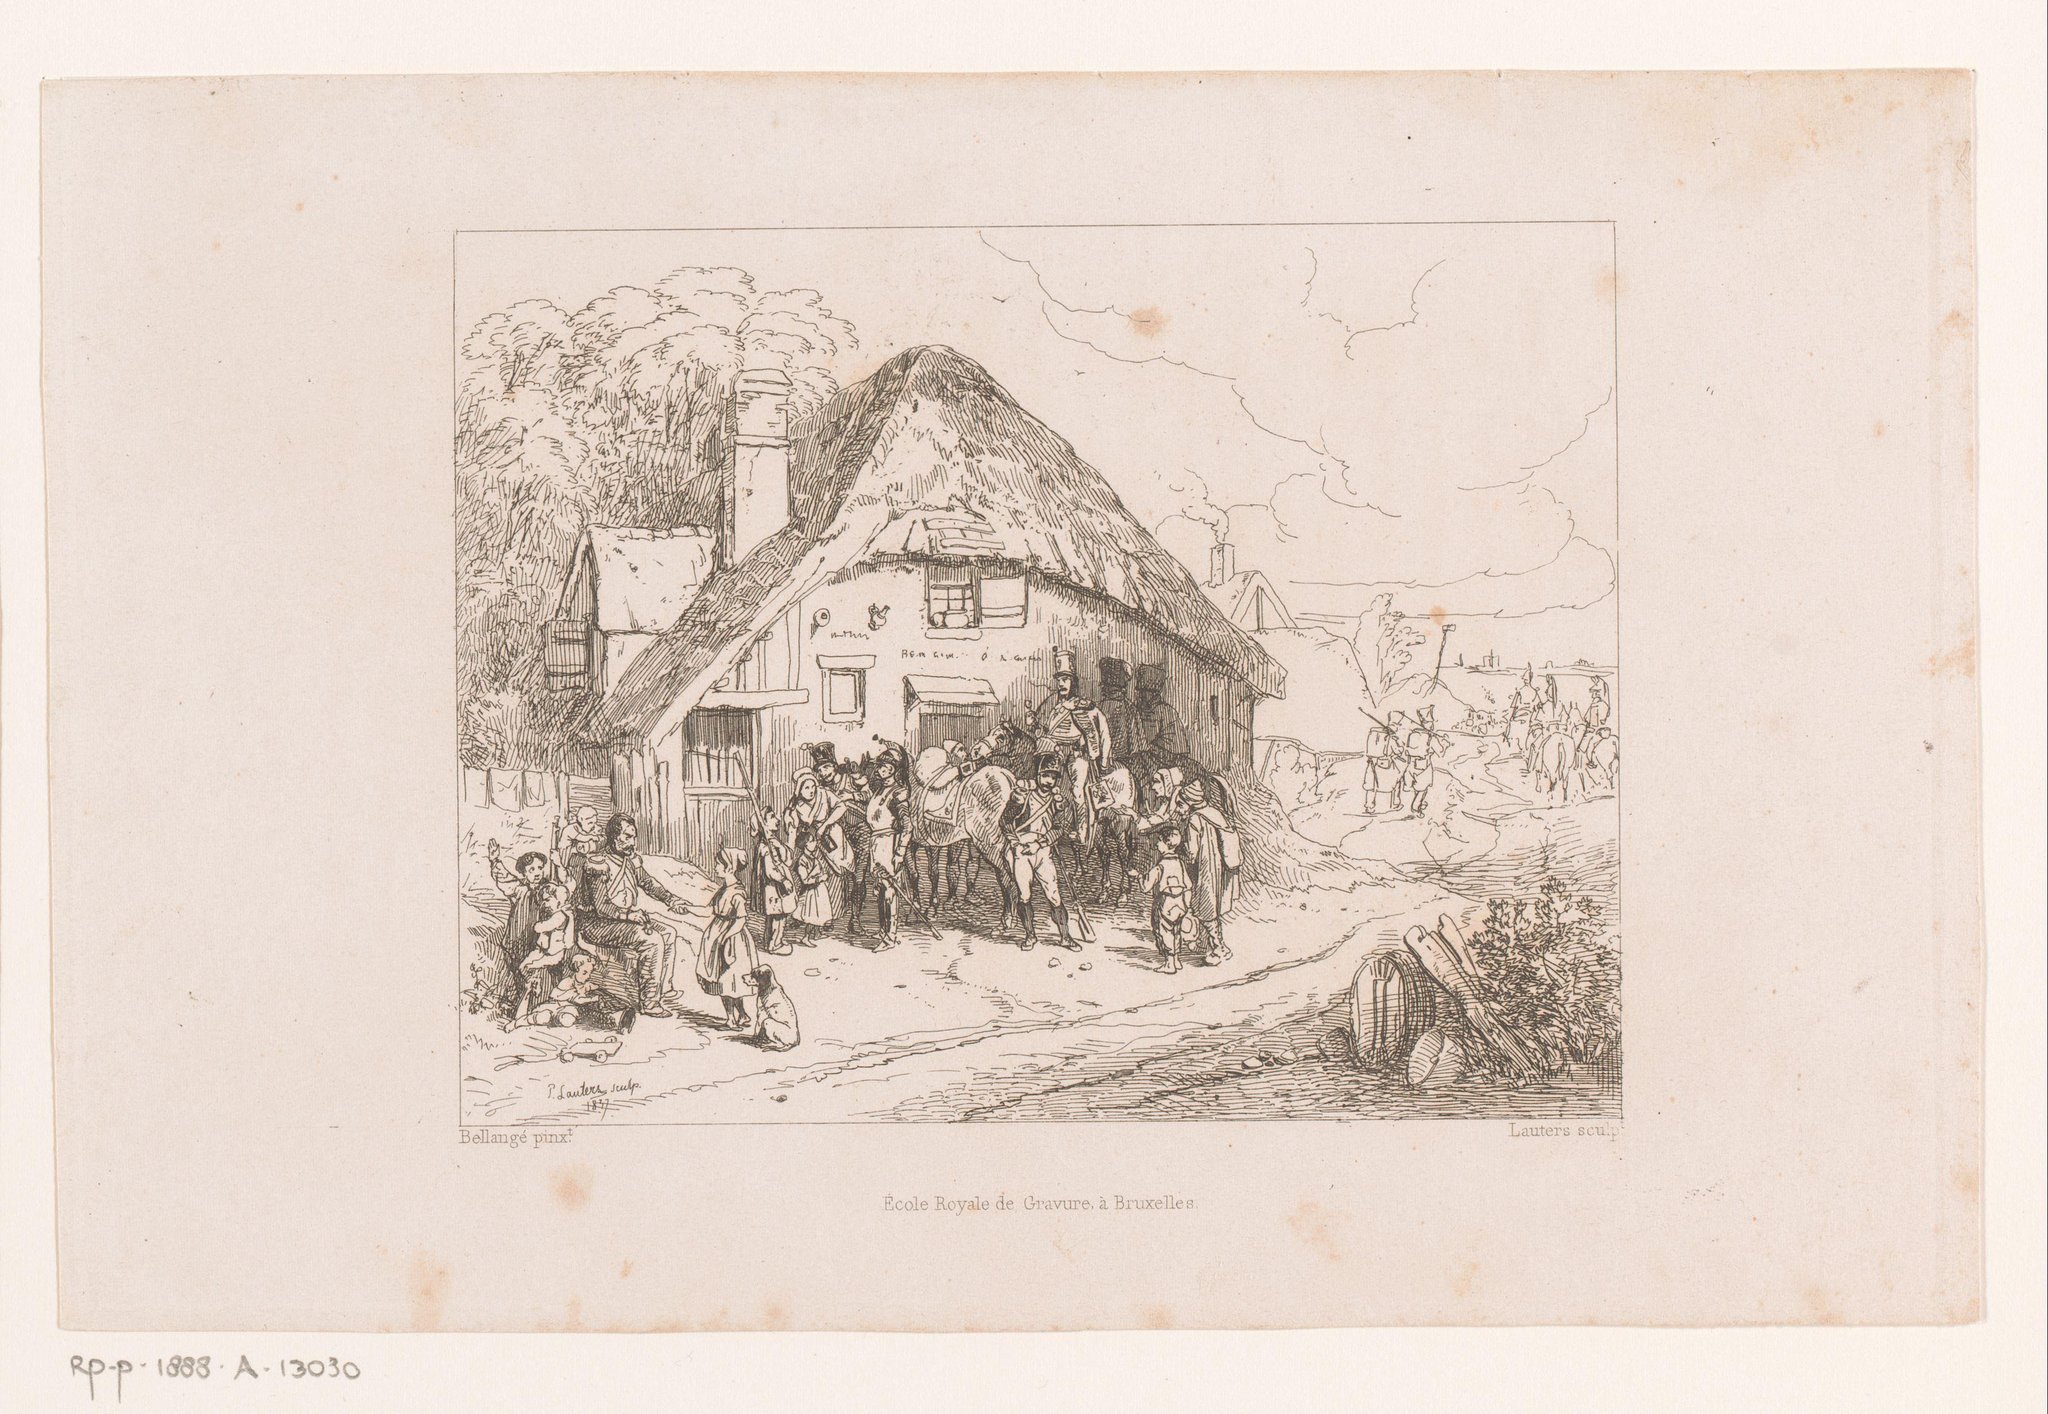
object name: print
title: Halte militaire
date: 1836-1837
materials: paper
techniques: etching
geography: brussels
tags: the soldier off duty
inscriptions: collector's mark: Lugt 2228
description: Prent uit: Alvin, Louis. Compte-rendu du salon d'exposition de Bruxelles, 1836. Brussel: J.P. Meline, 1836, p. 201.